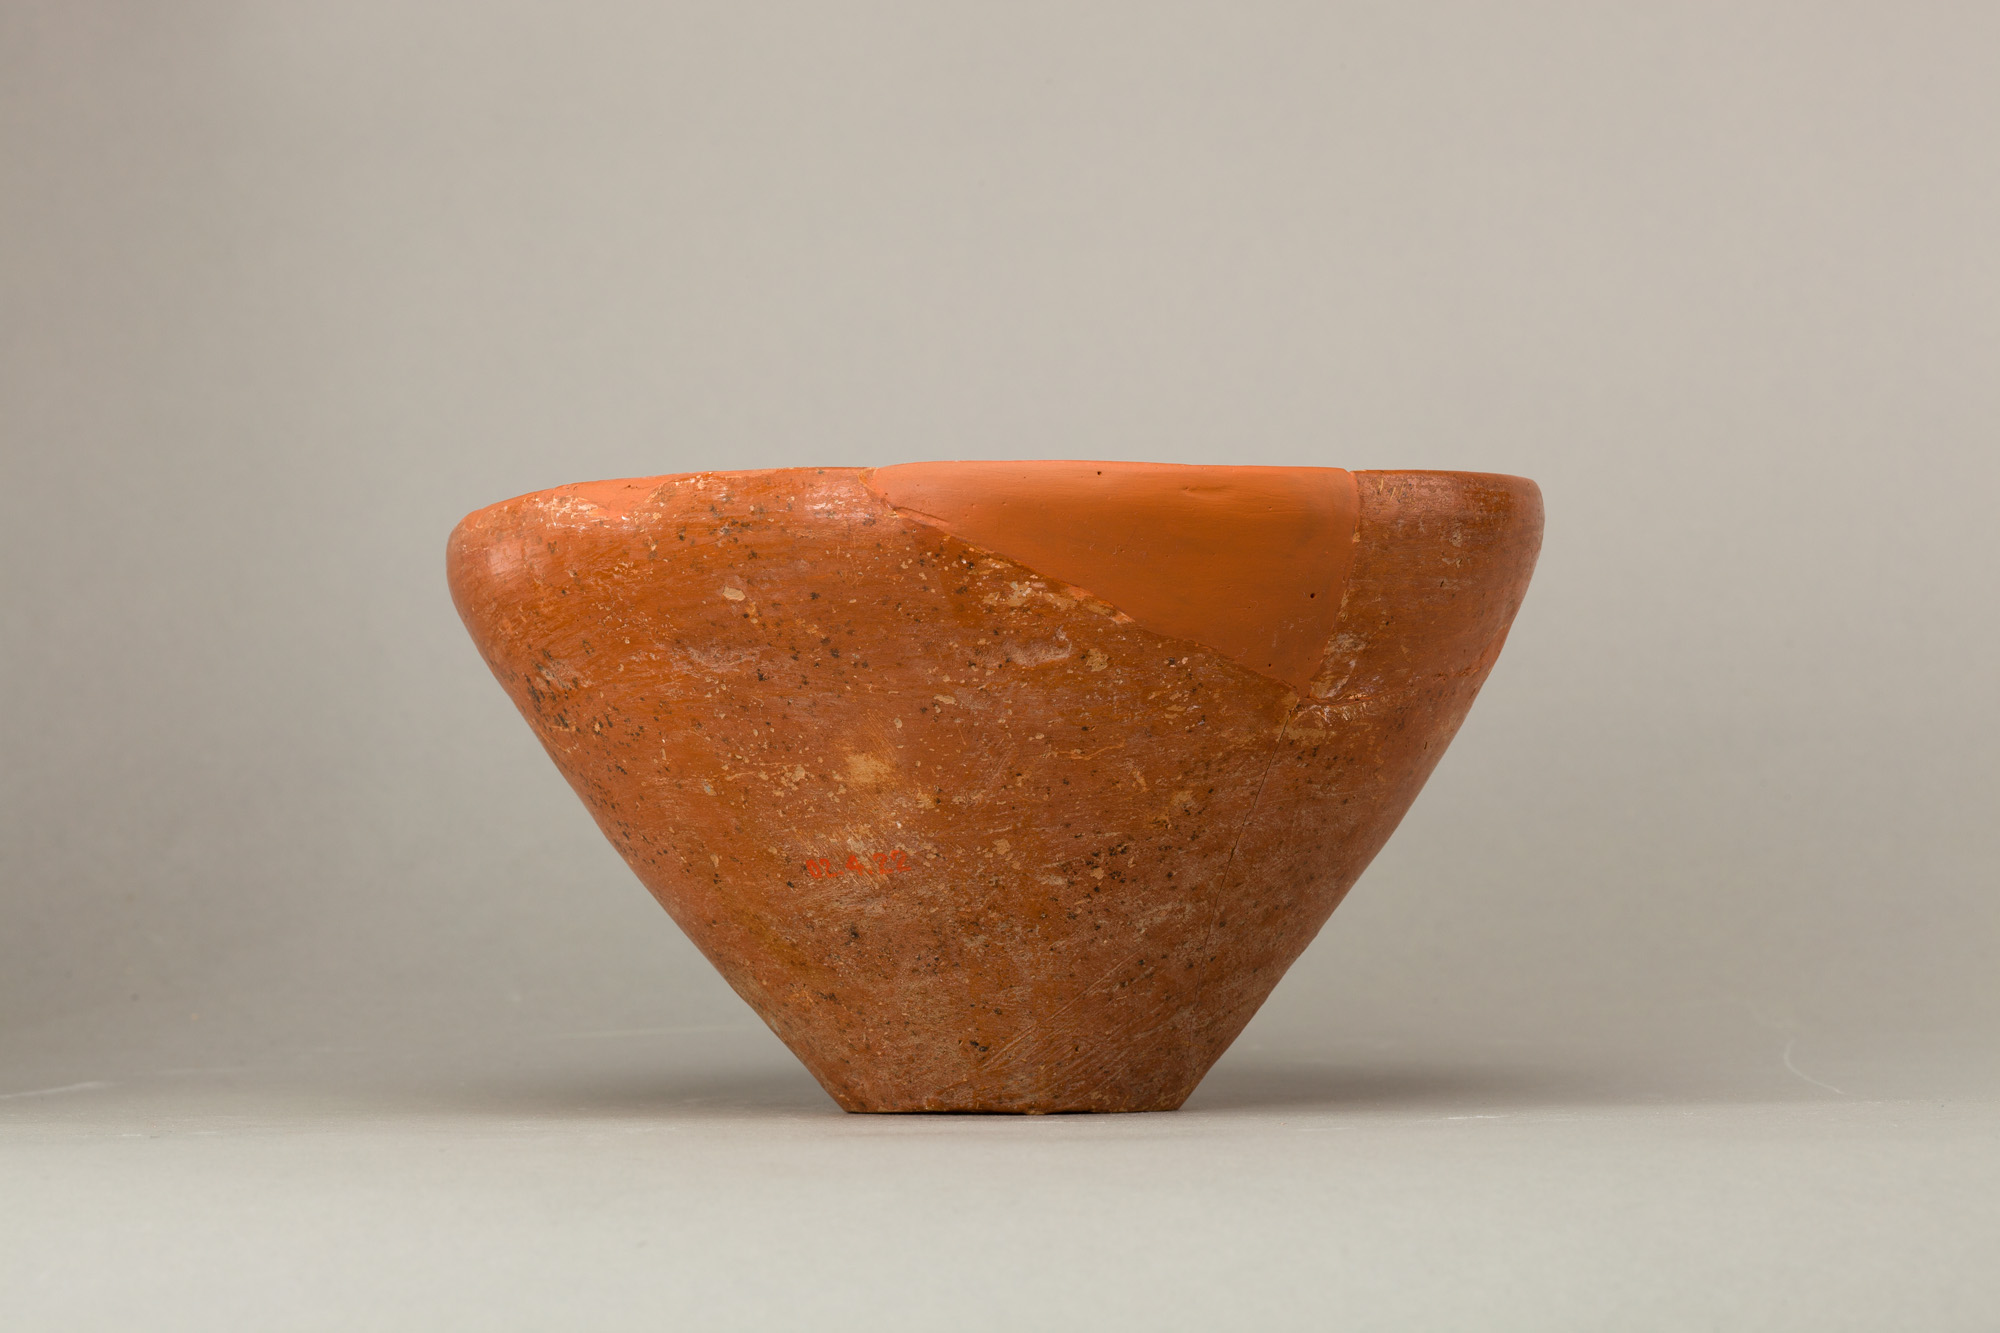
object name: bowl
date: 2960-2770 BCE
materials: pottery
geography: egypt